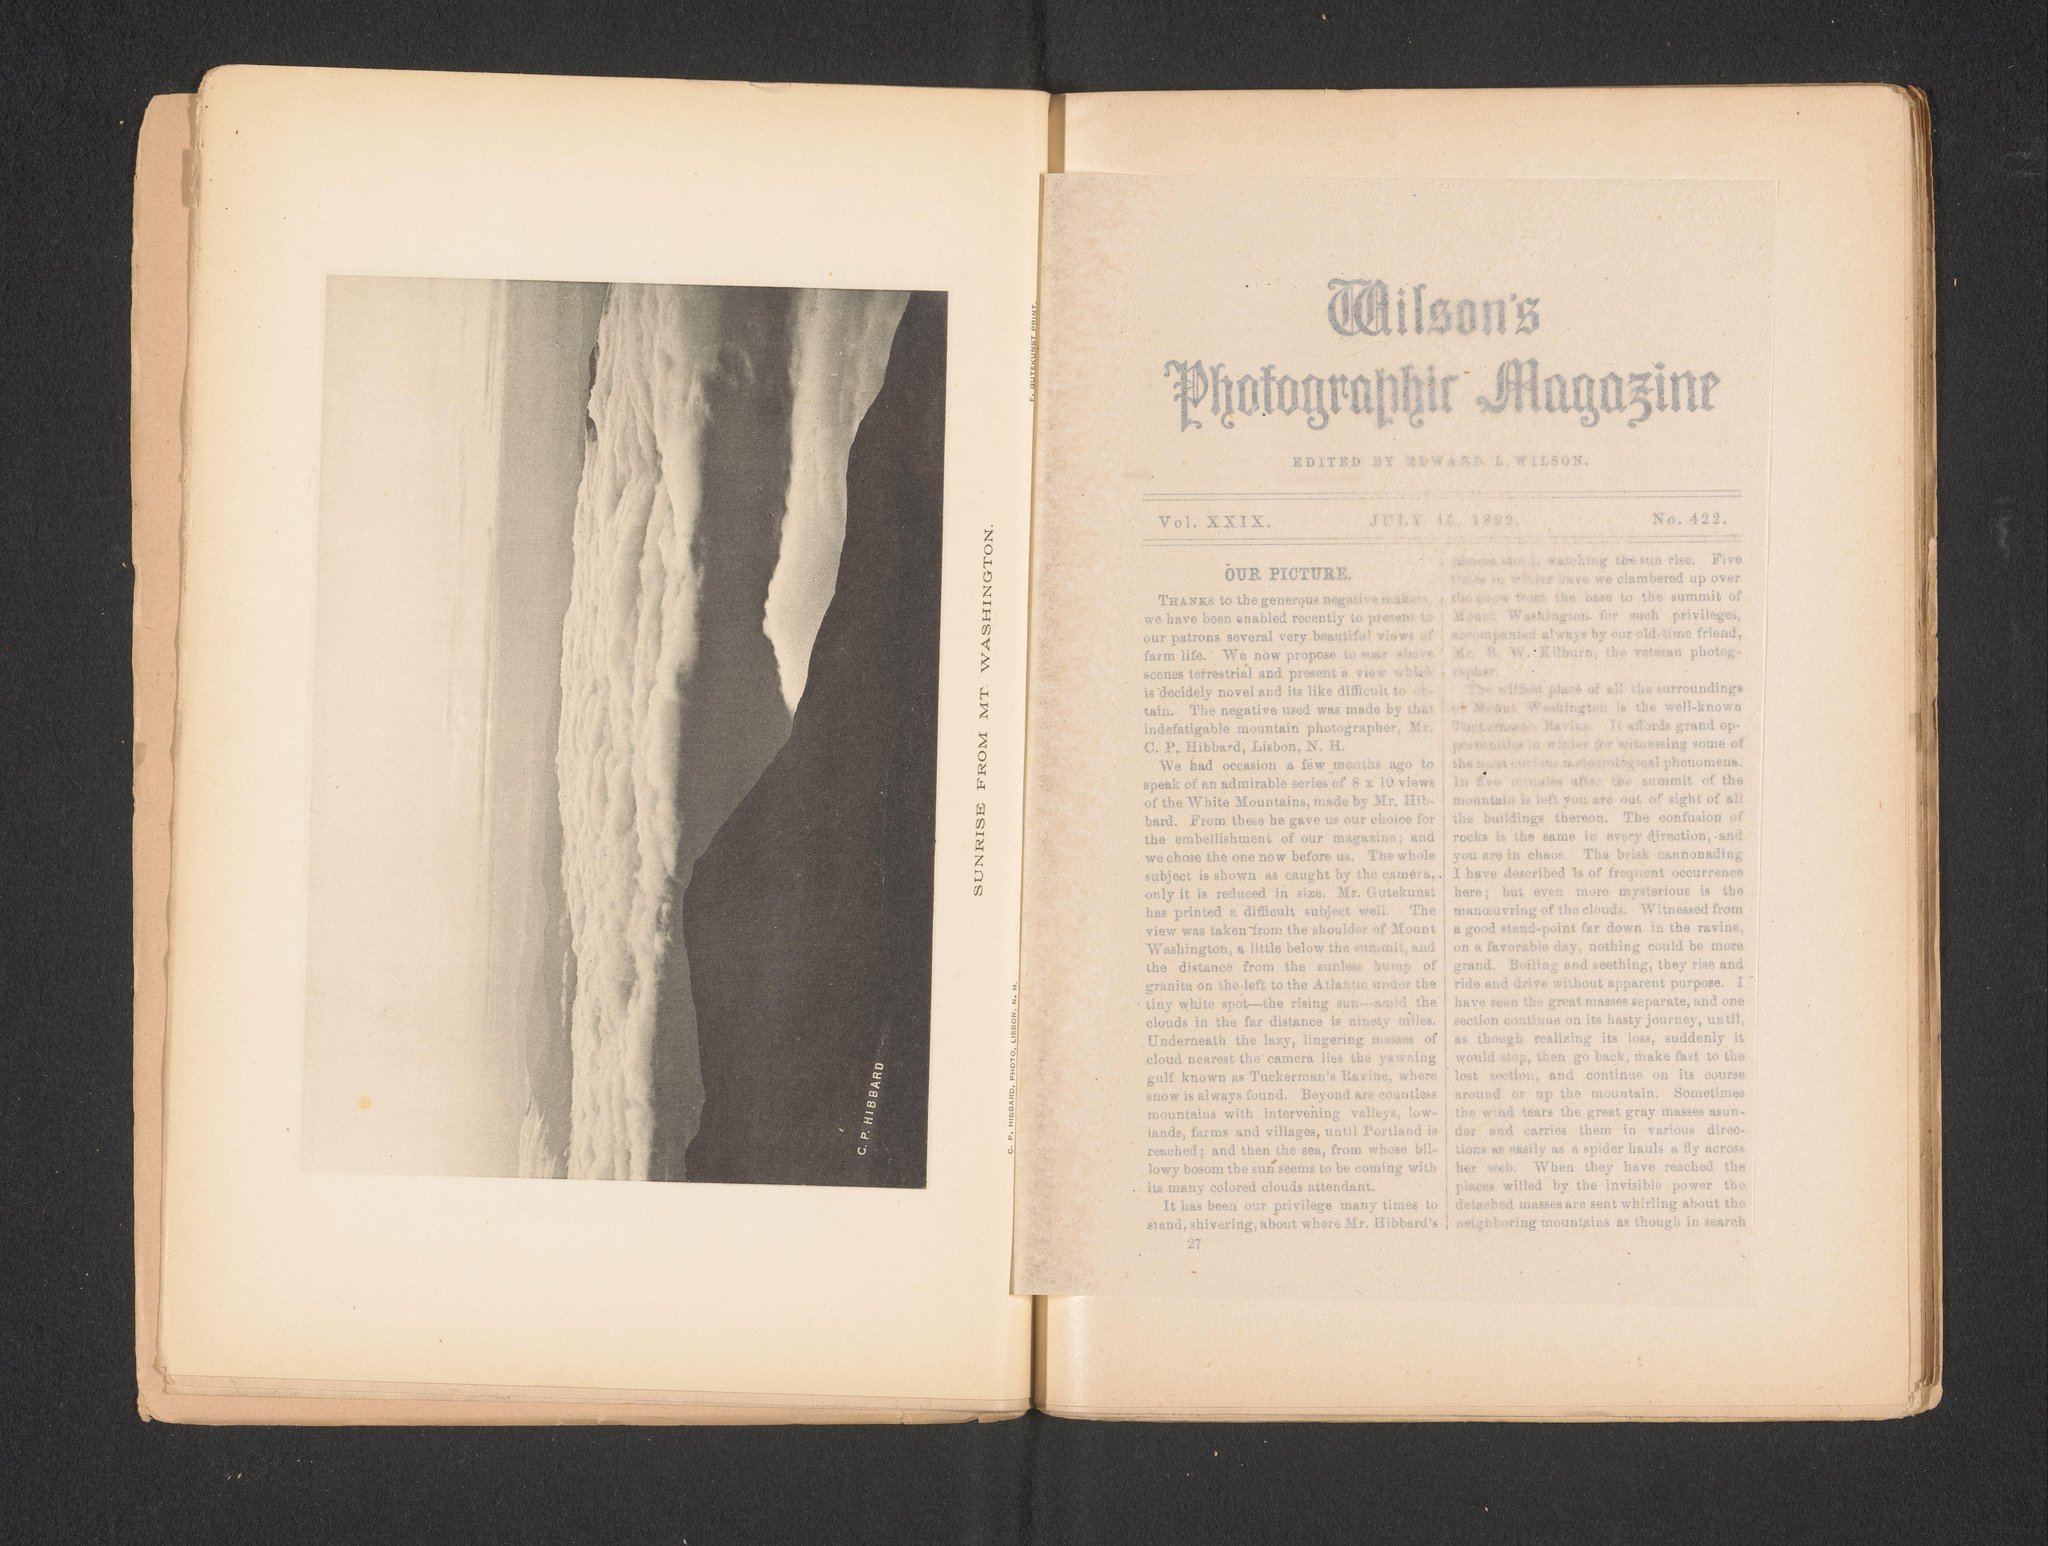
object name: page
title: Zonsondergang, gezien vanaf Mount Washington, New Hampshire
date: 1887-1892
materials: paper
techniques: photograph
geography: philadelphia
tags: sunrise, mountains